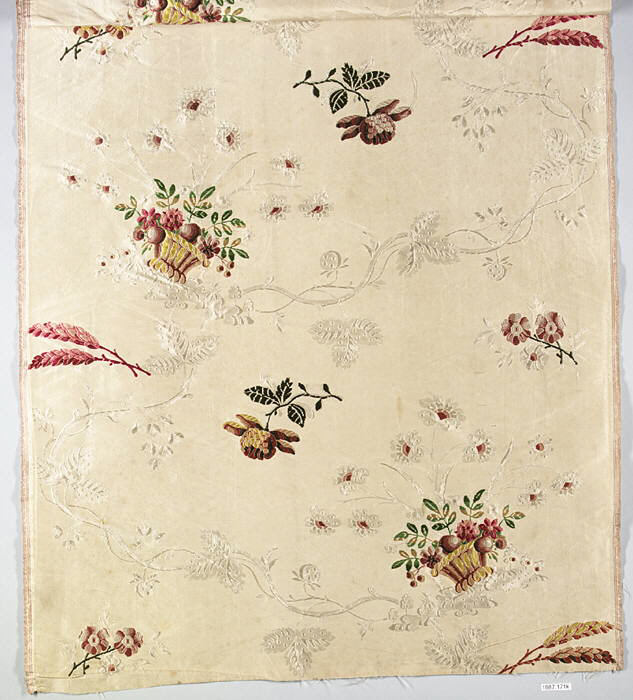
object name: length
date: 1750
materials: silk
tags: flowers